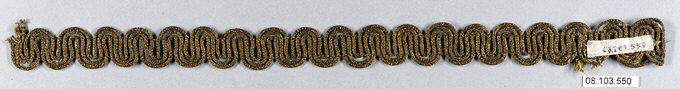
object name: galloon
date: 1701-1800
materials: metal thread